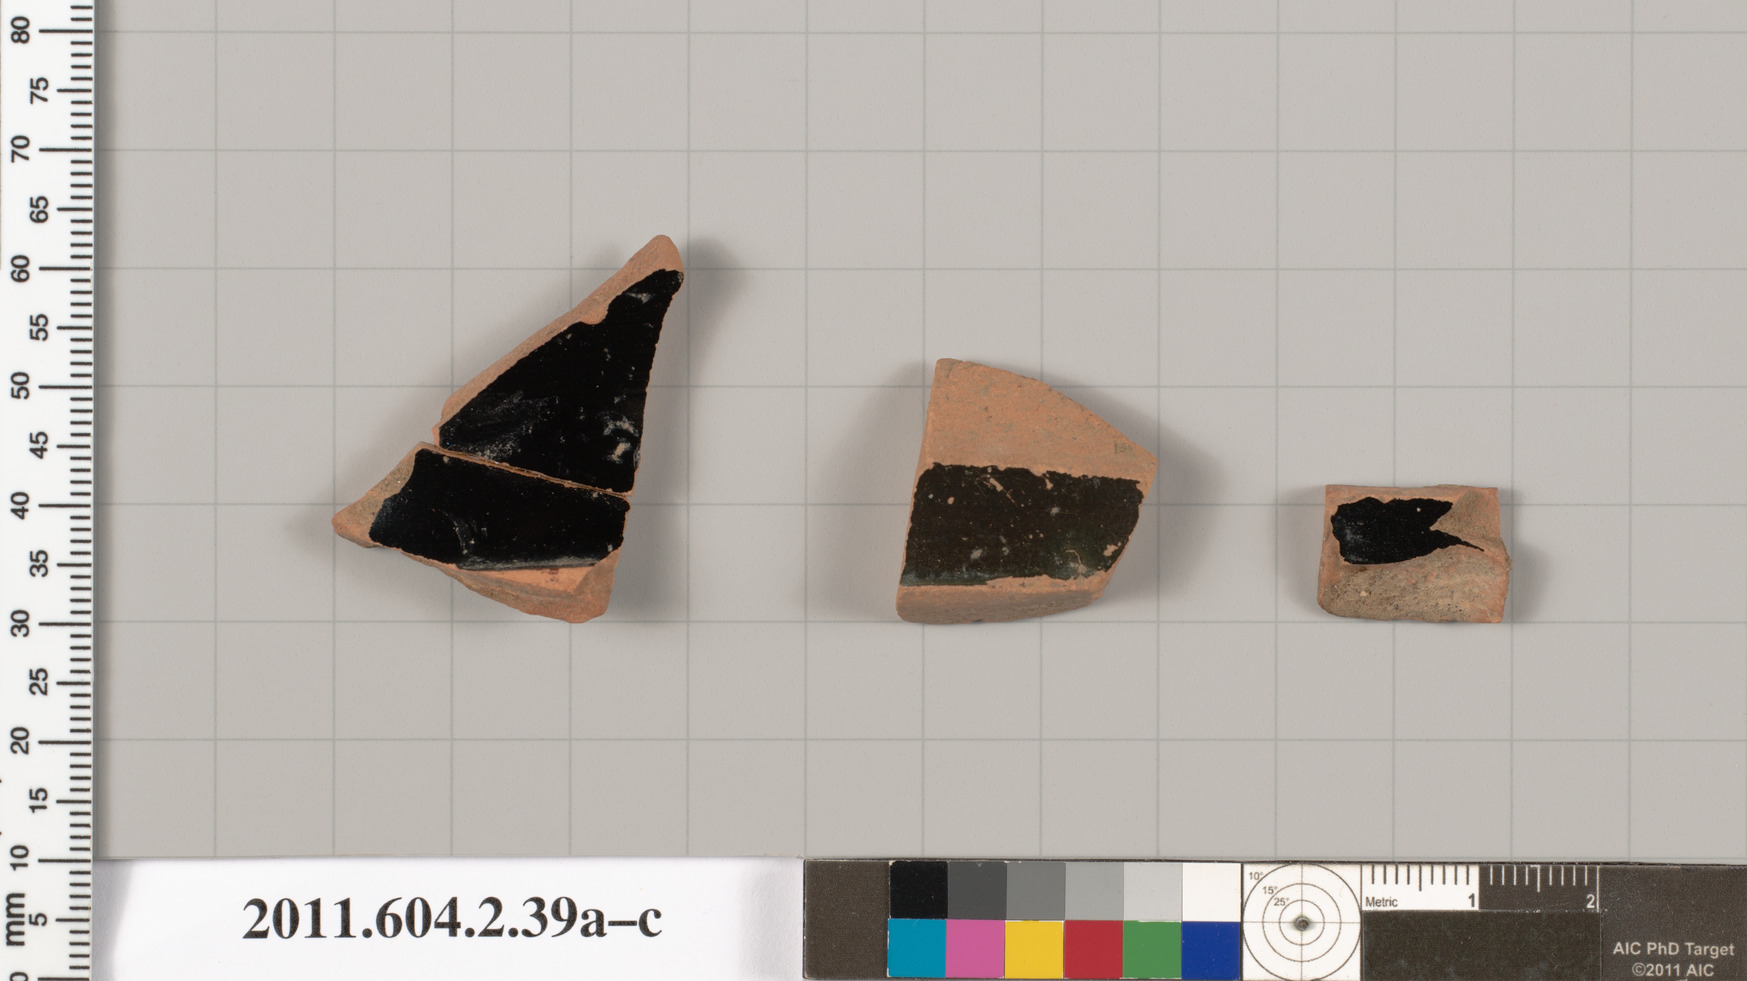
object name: psykter fragment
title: Terracotta fragments of a psykter (vase for cooling wine)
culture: greek, attic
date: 534-468 BCE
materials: terracotta